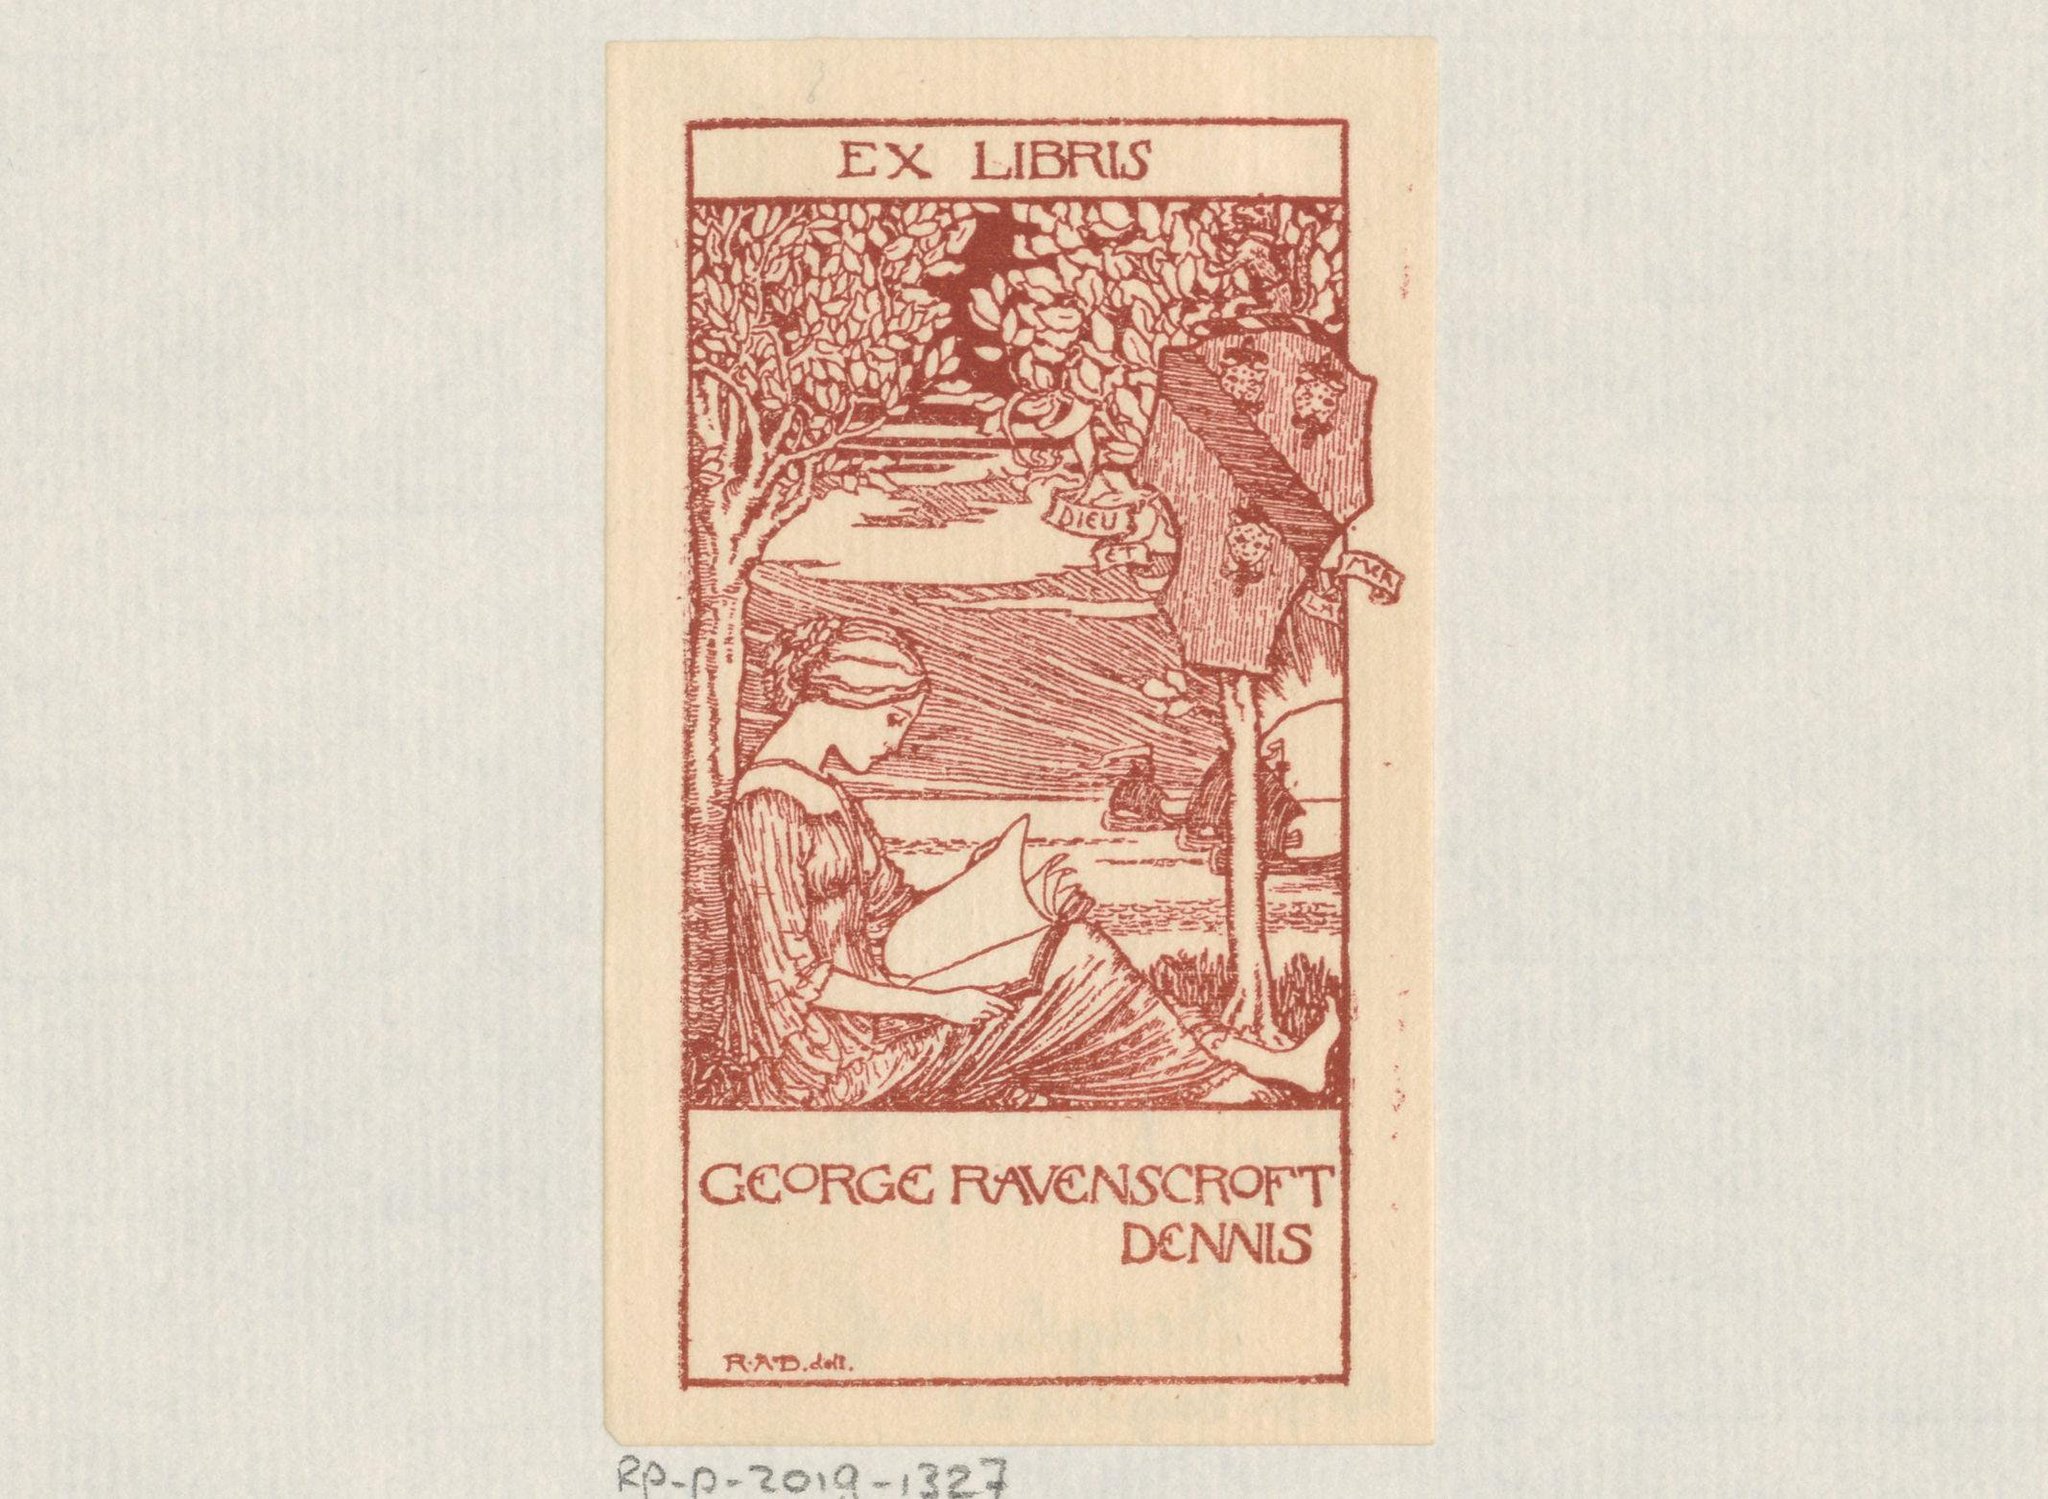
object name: bookplate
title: Ex libris van George Ravenscroft Dennis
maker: robert anning bell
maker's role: painter, print maker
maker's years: 1863-1933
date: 1893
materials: paper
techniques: printing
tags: reading, armorial bearing, heraldry